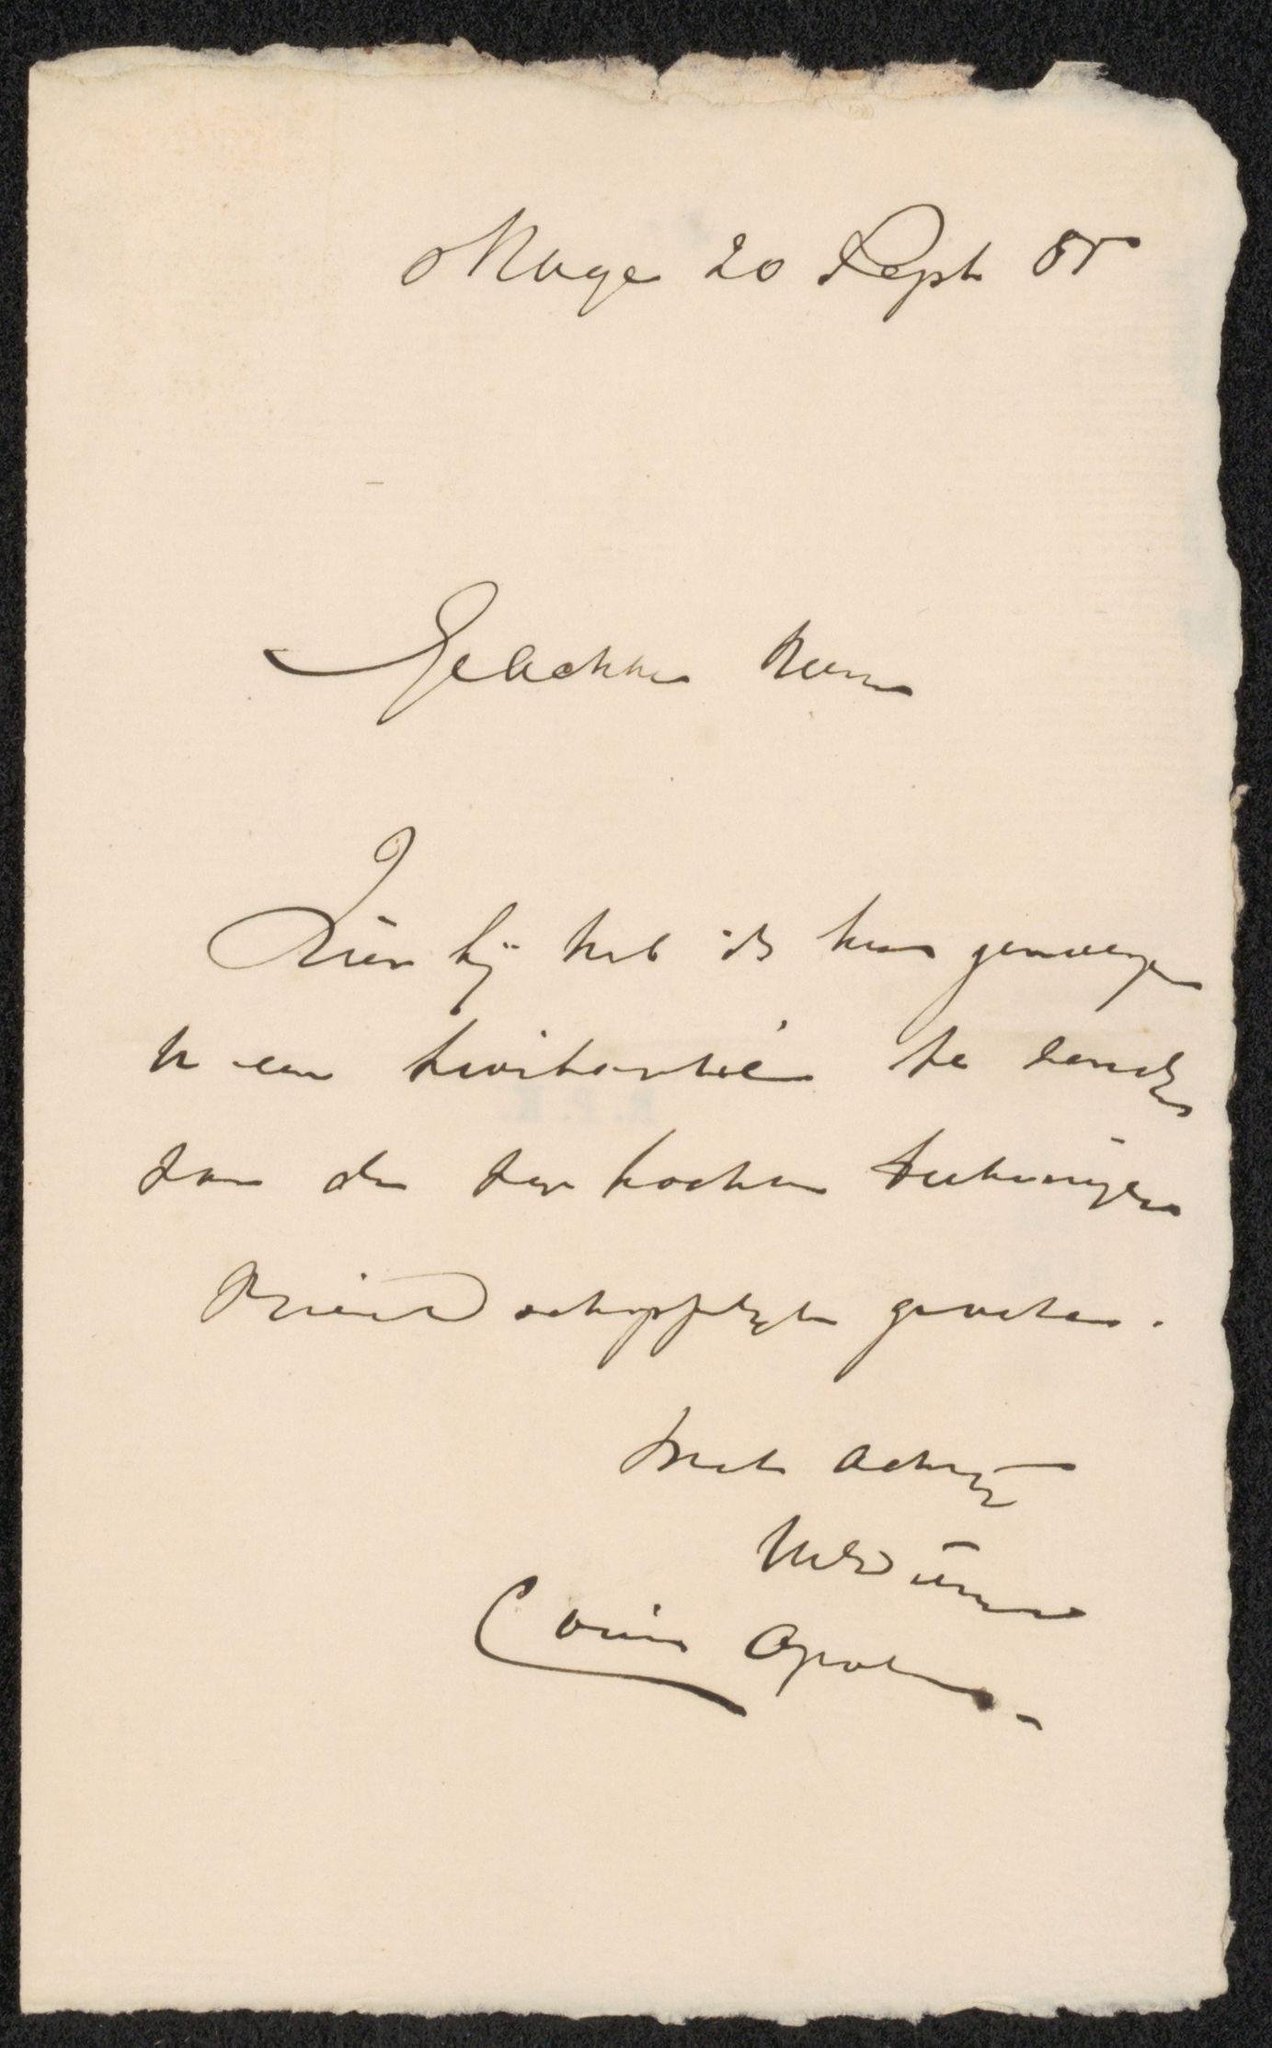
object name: letter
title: Brief Frans Buffa en Zonen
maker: louis apol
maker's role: draughtsman, painter, print maker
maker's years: 1850-1936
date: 1885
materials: ink, paper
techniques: pen, writing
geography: the hague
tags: publisher, the hague, painter, print maker, draughtsman, louis apol, drawing, money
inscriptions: name: ‘HAAGSCHE BANKVEREENIGING/ FELIX POLAK & Co./ 's GRAVENHAGE’, watermark, collector's mark: Lugt 2233